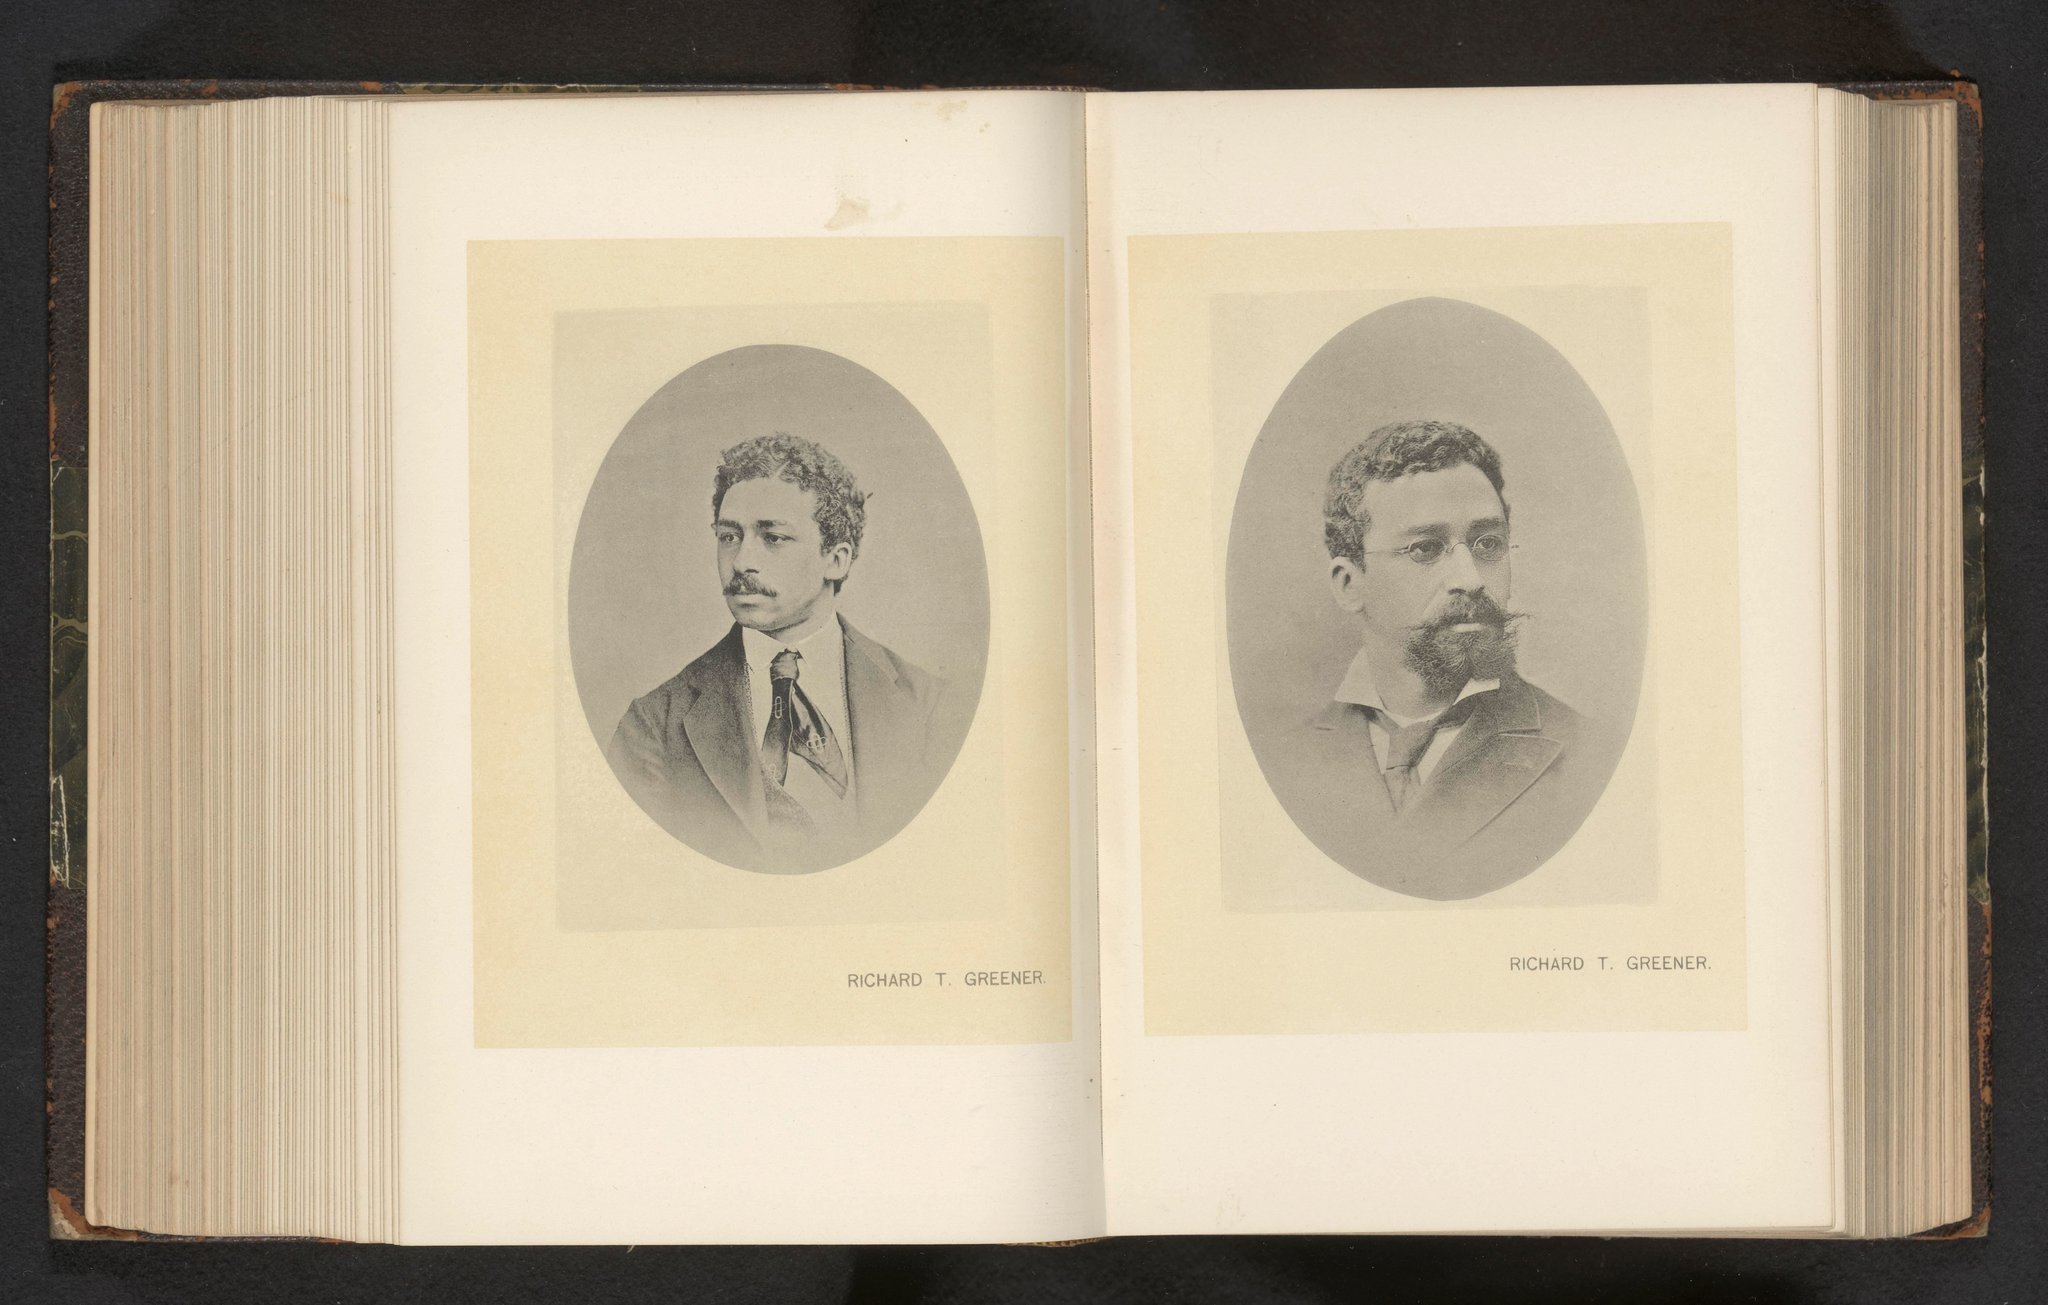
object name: page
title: Richard T. Greener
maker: Anonymous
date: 1869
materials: paper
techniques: photoaquatint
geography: boston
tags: adult man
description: Richard Theodore Greener was de eerste Afro-Amerikaanse afgestudeerde van Harvard College.